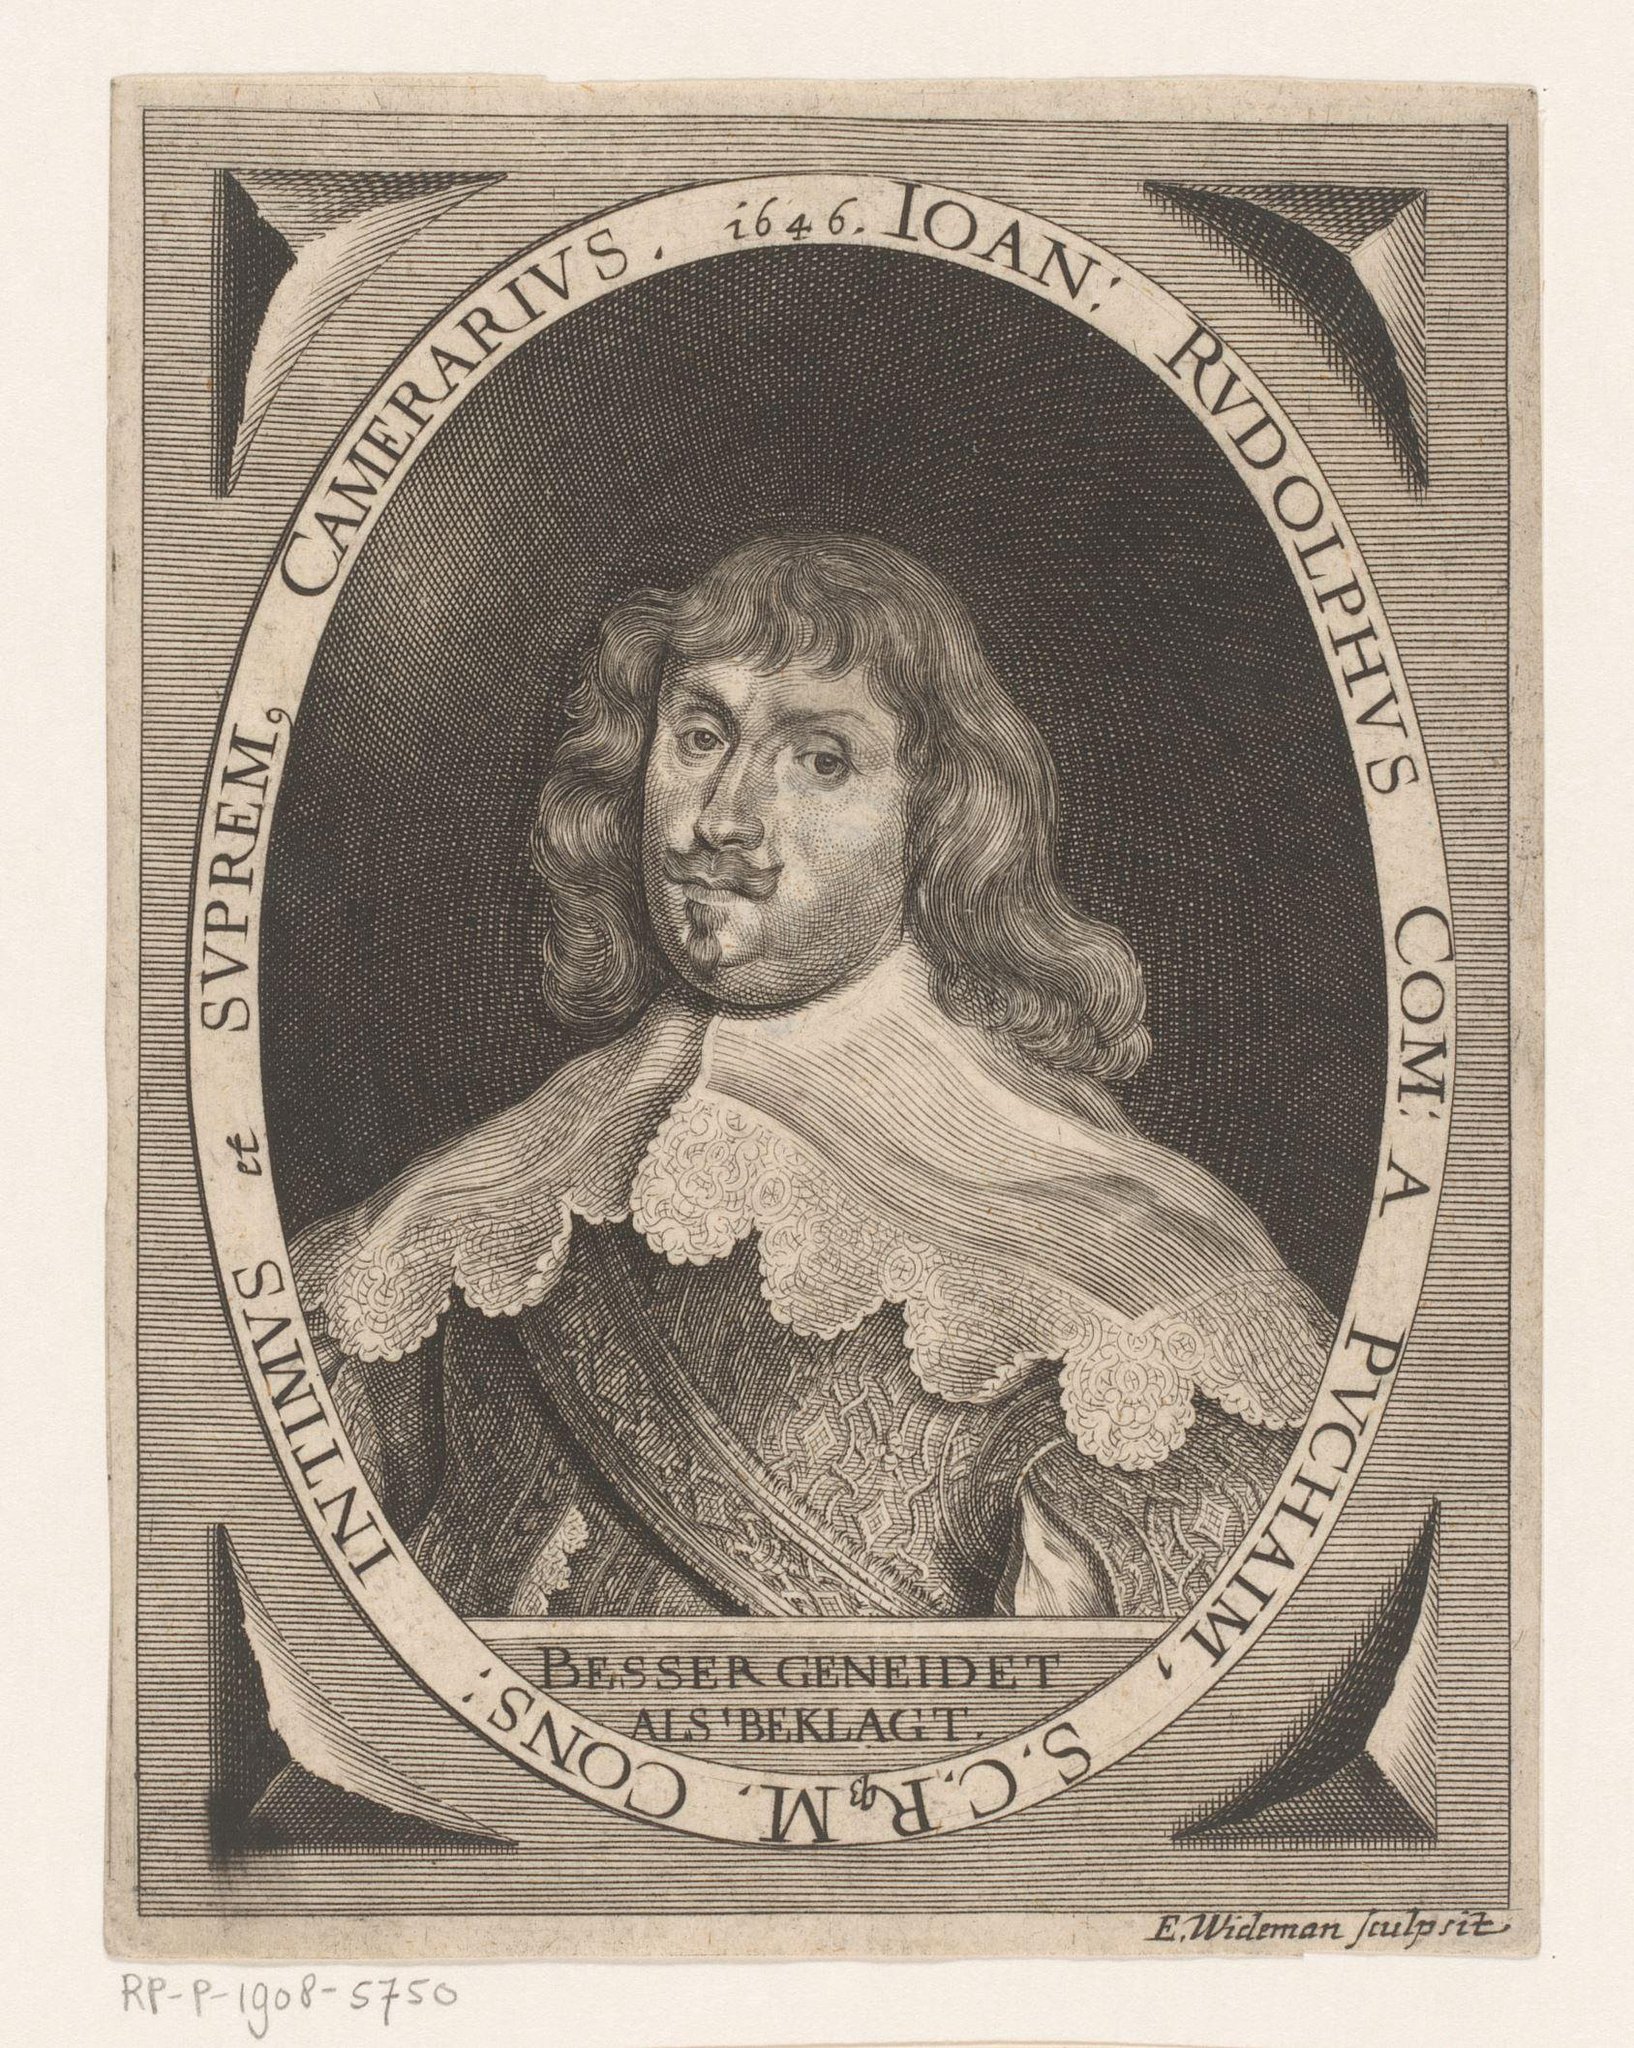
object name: print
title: Portret van Johann Rudolph von Puchaim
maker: elias widemann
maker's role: print maker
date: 1646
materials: paper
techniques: engraving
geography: vienna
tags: historical persons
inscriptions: collector's mark: Lugt 2228